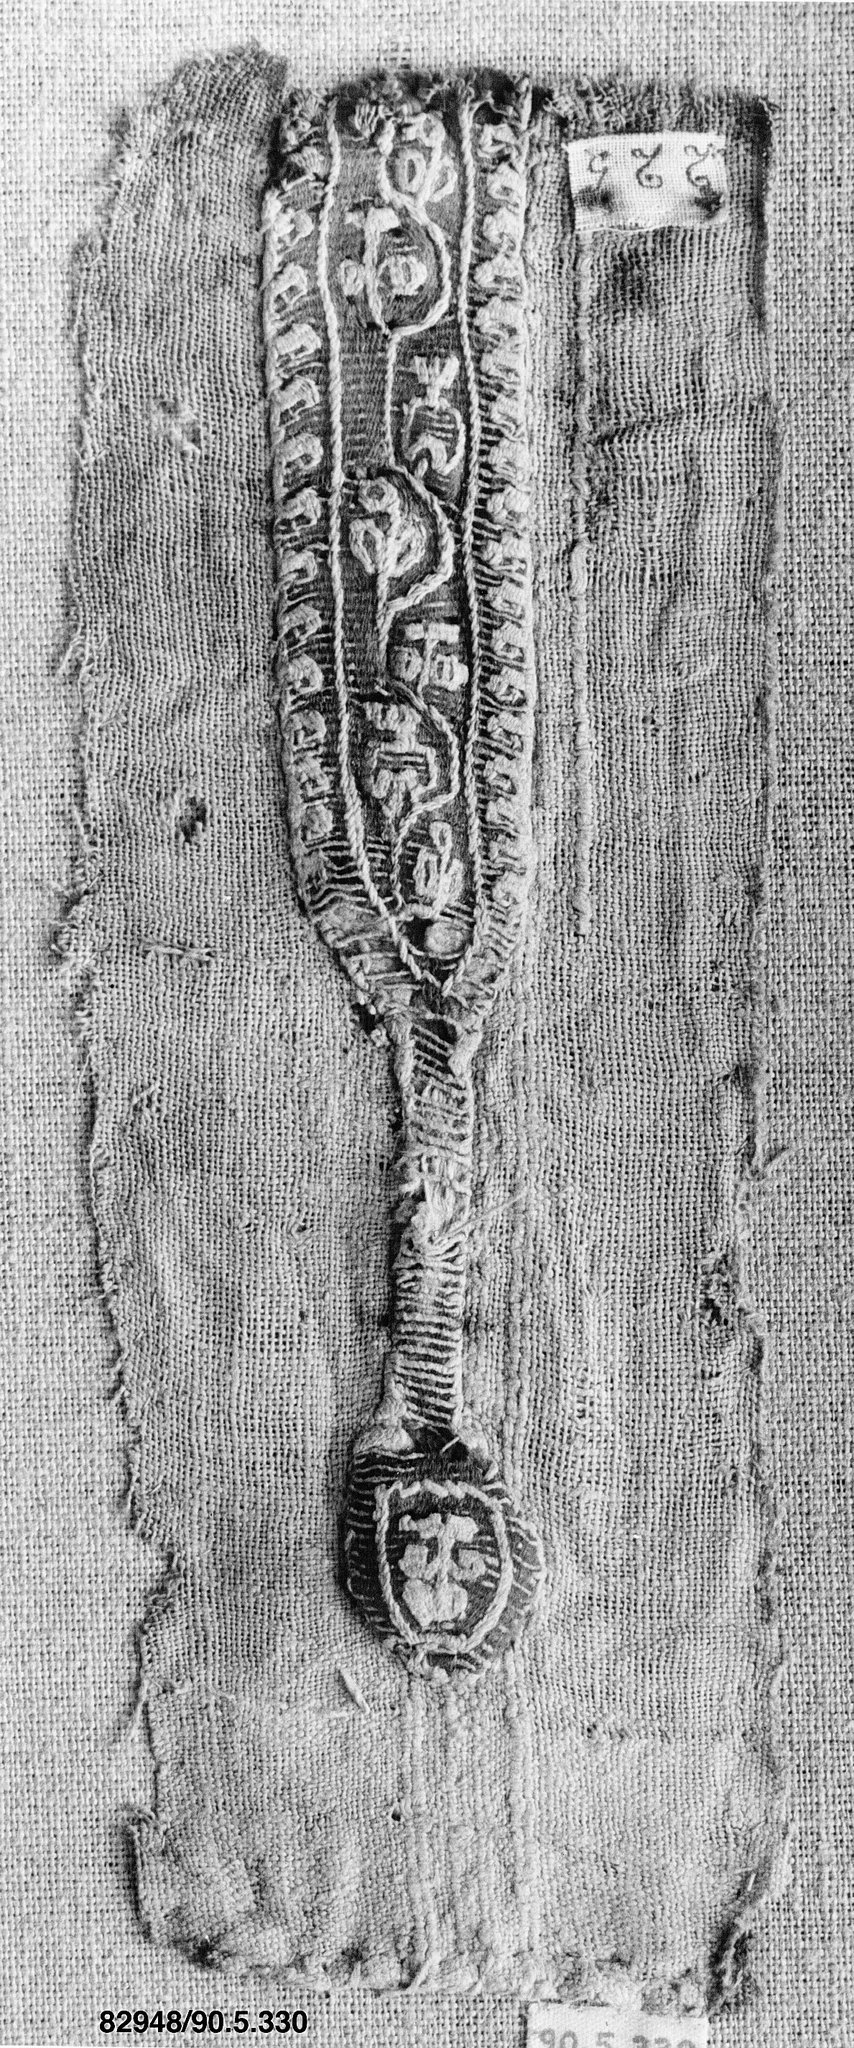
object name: textile fragment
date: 201-400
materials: linen, wool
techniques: weave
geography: egypt